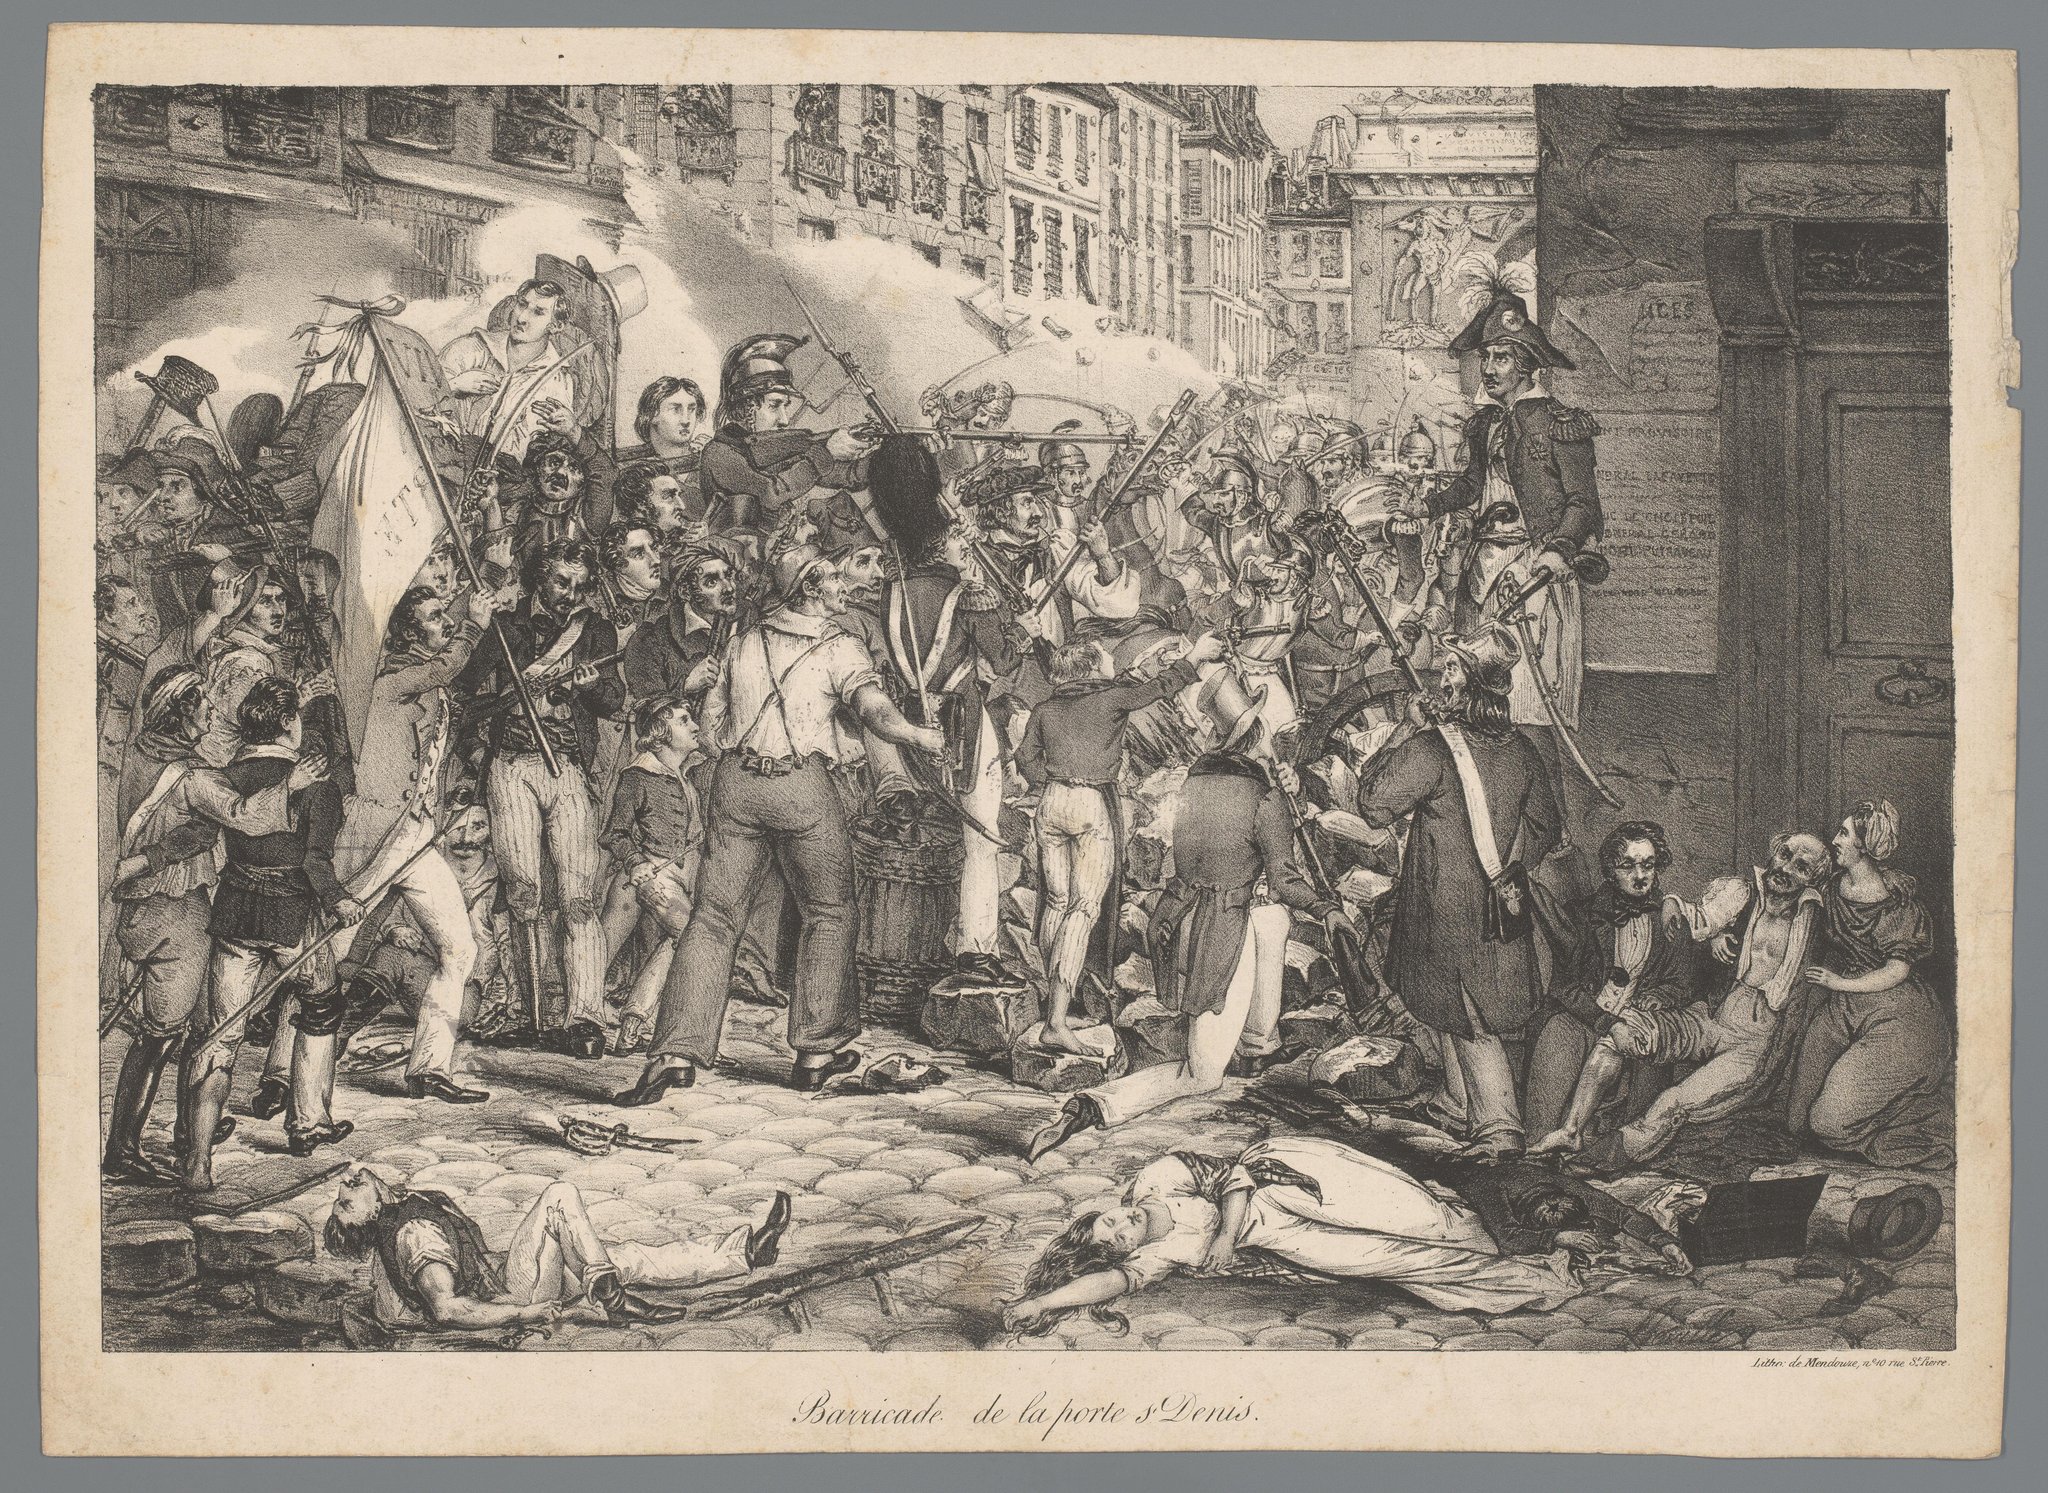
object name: print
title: Mensenmenigte verspert straat bij de Porte Saint-Denis in Parijs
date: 1828-1834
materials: paper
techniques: lithograph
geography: paris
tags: revolution, revolt, paris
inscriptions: collector's mark: Lugt 2228